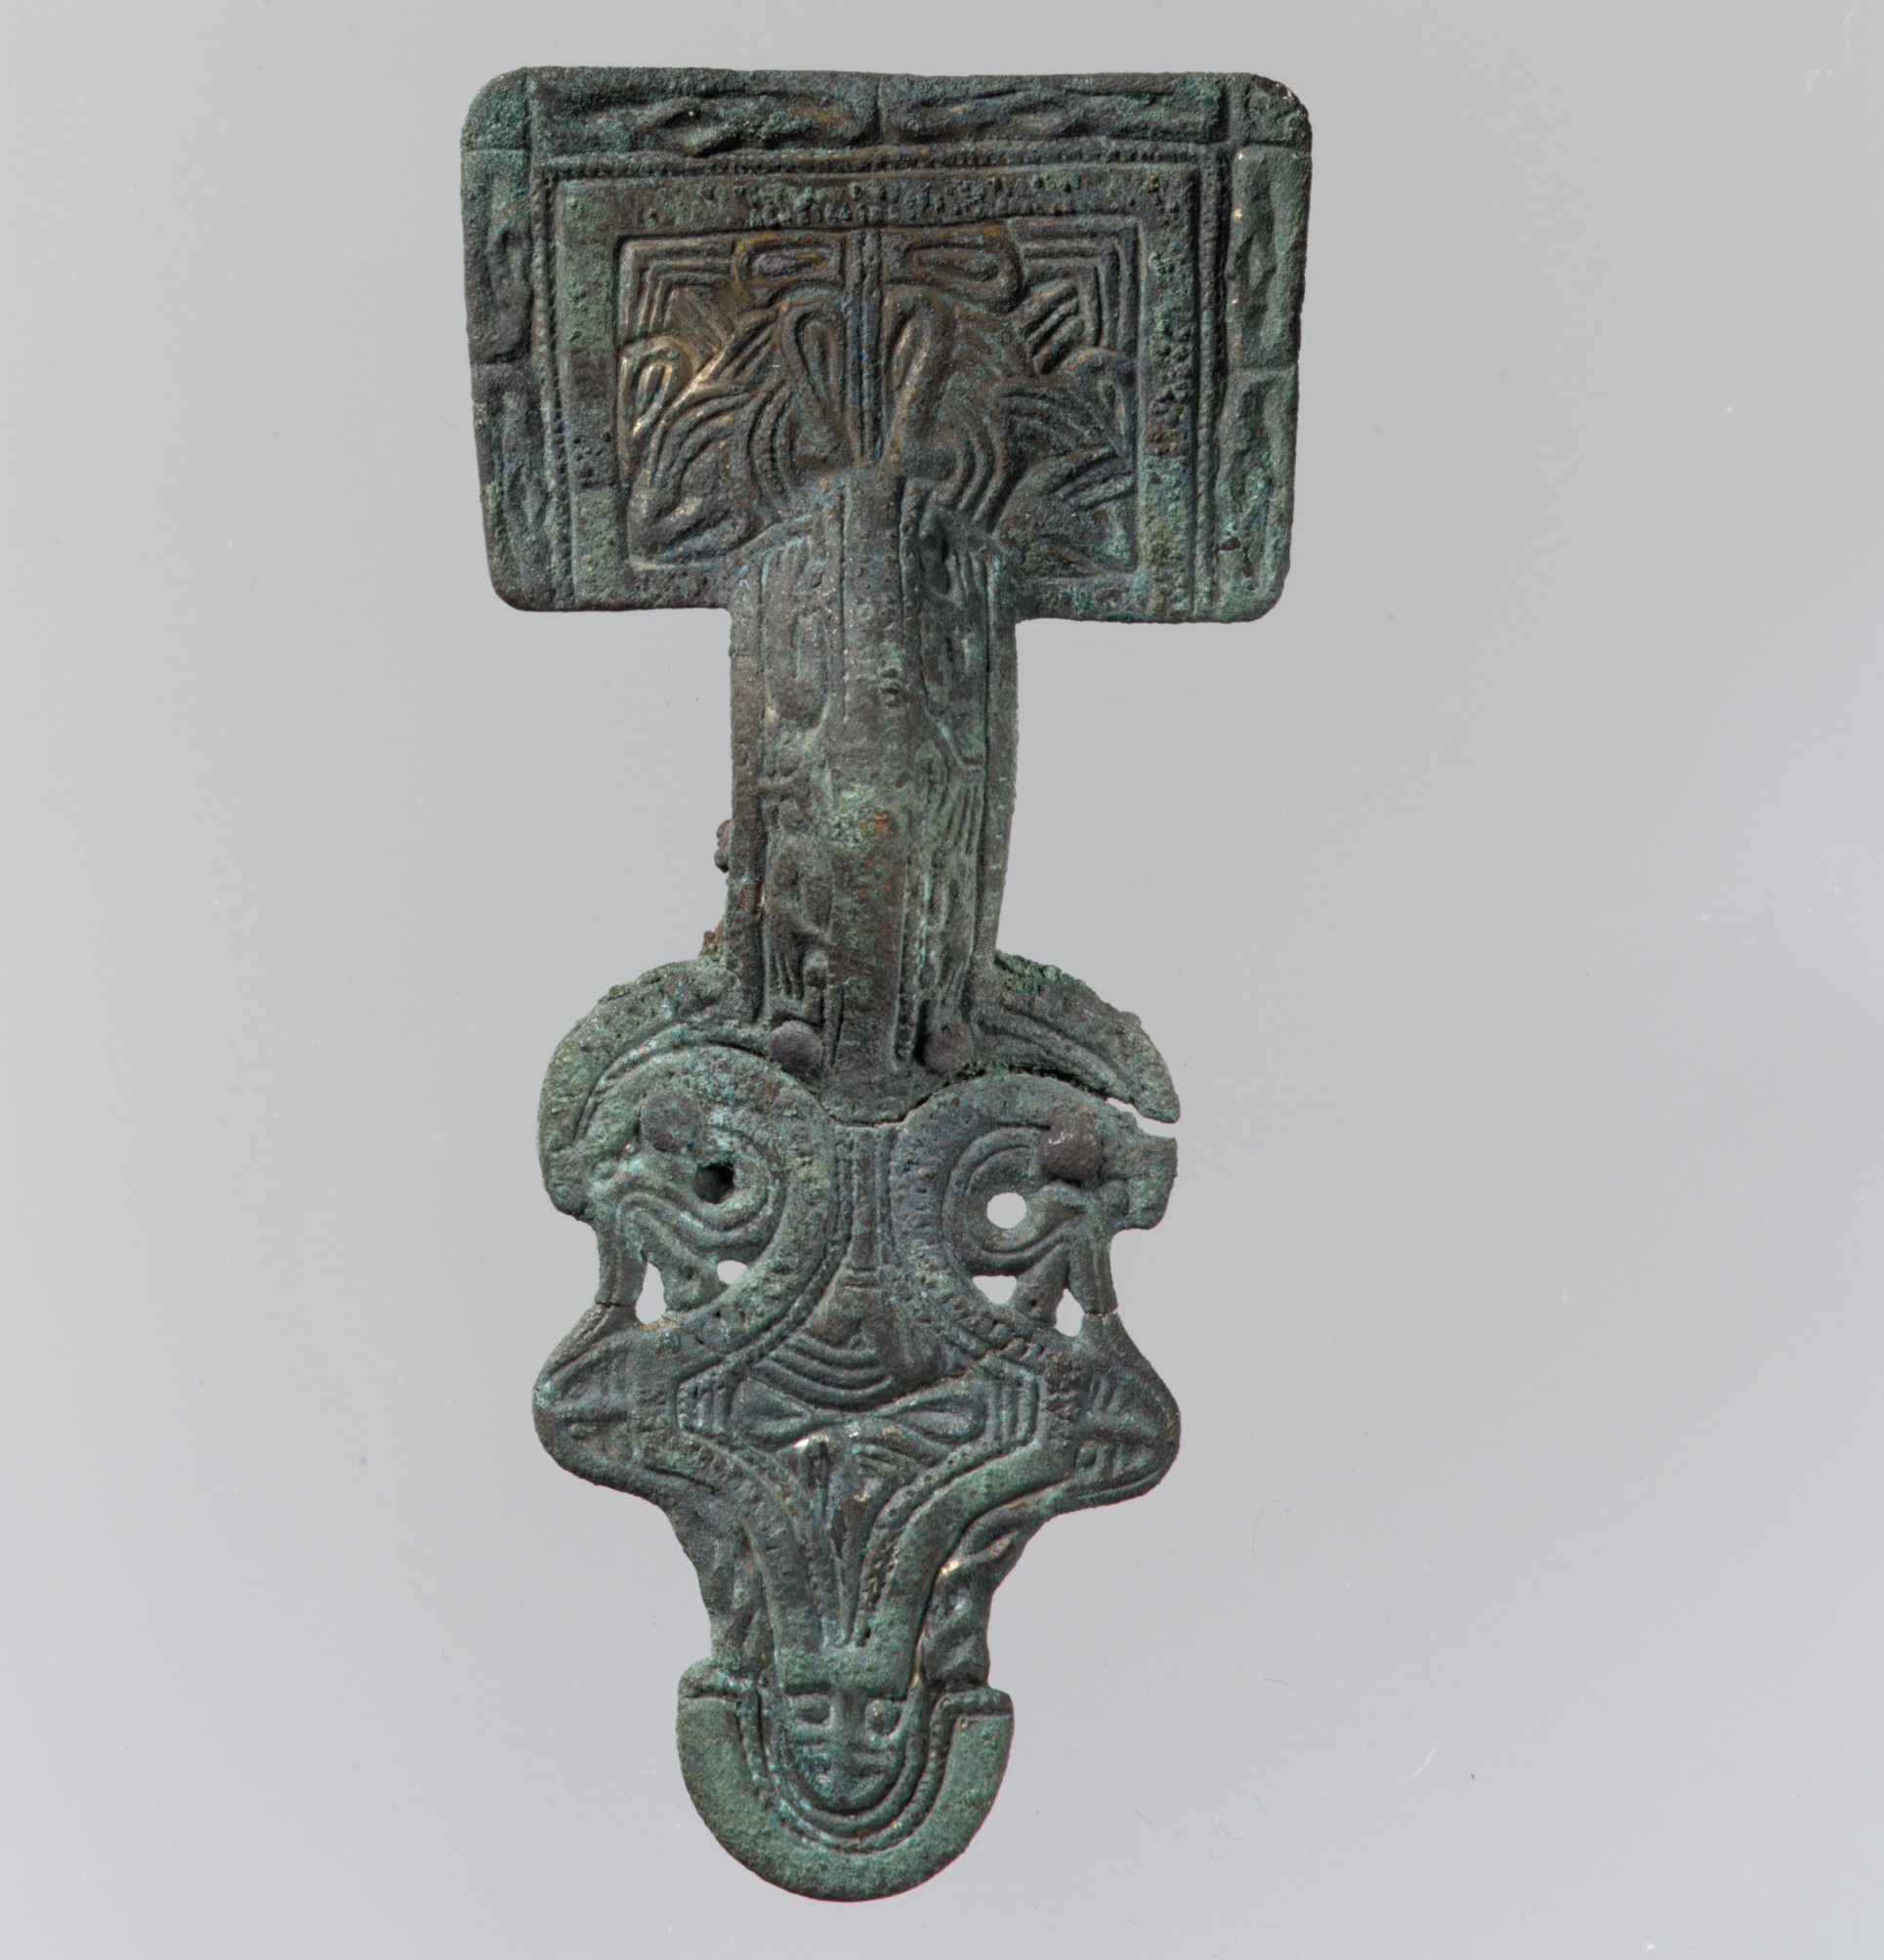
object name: brooch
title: Square-Headed Bow Brooch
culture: frankish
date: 530-560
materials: iron, niello, silver gilt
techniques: inlay